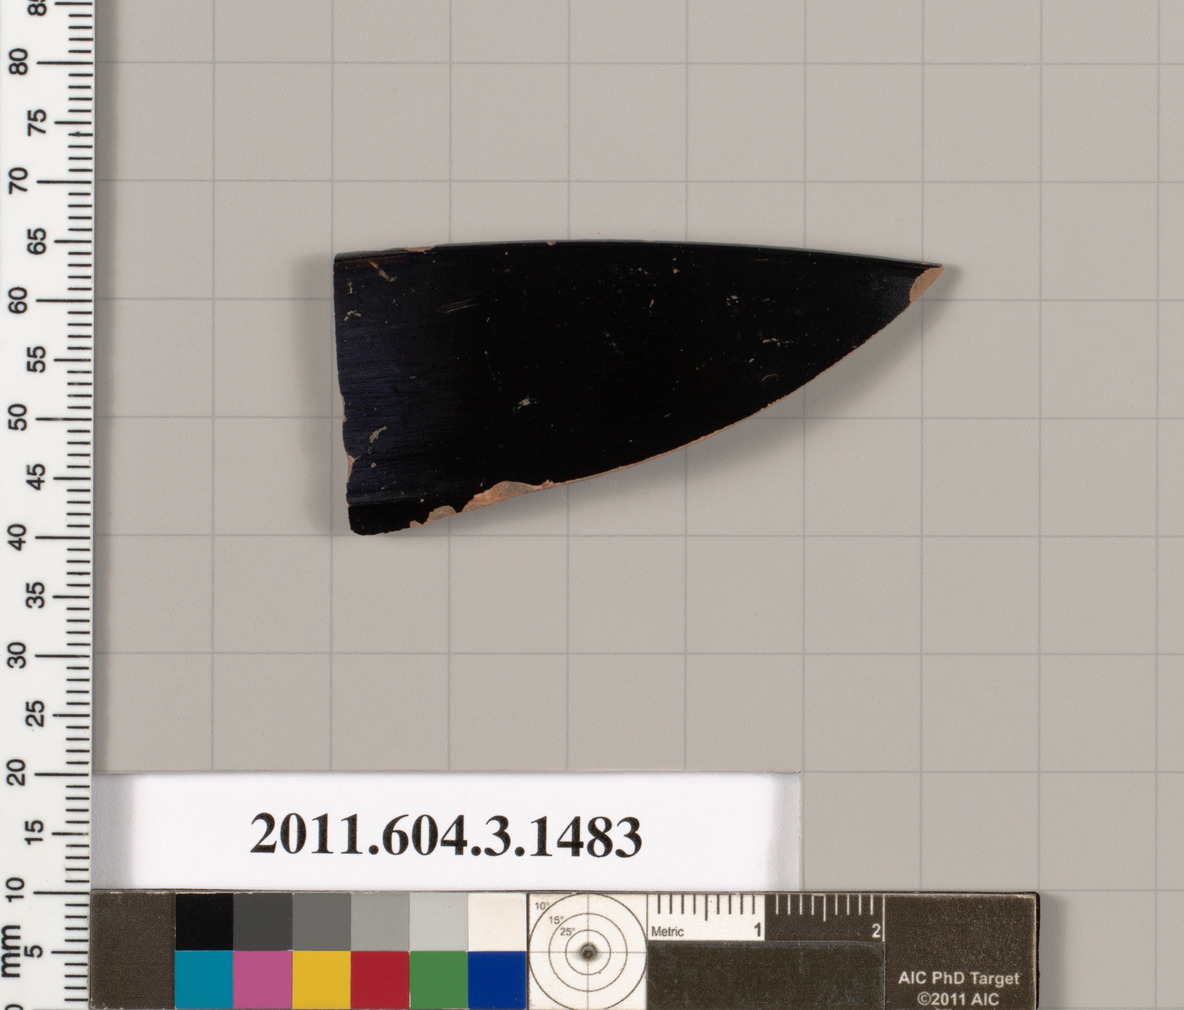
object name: skyphos fragment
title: Terracotta rim fragment of a skyphos (deep drinking cup)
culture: greek, attic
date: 600-401 BCE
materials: terracotta